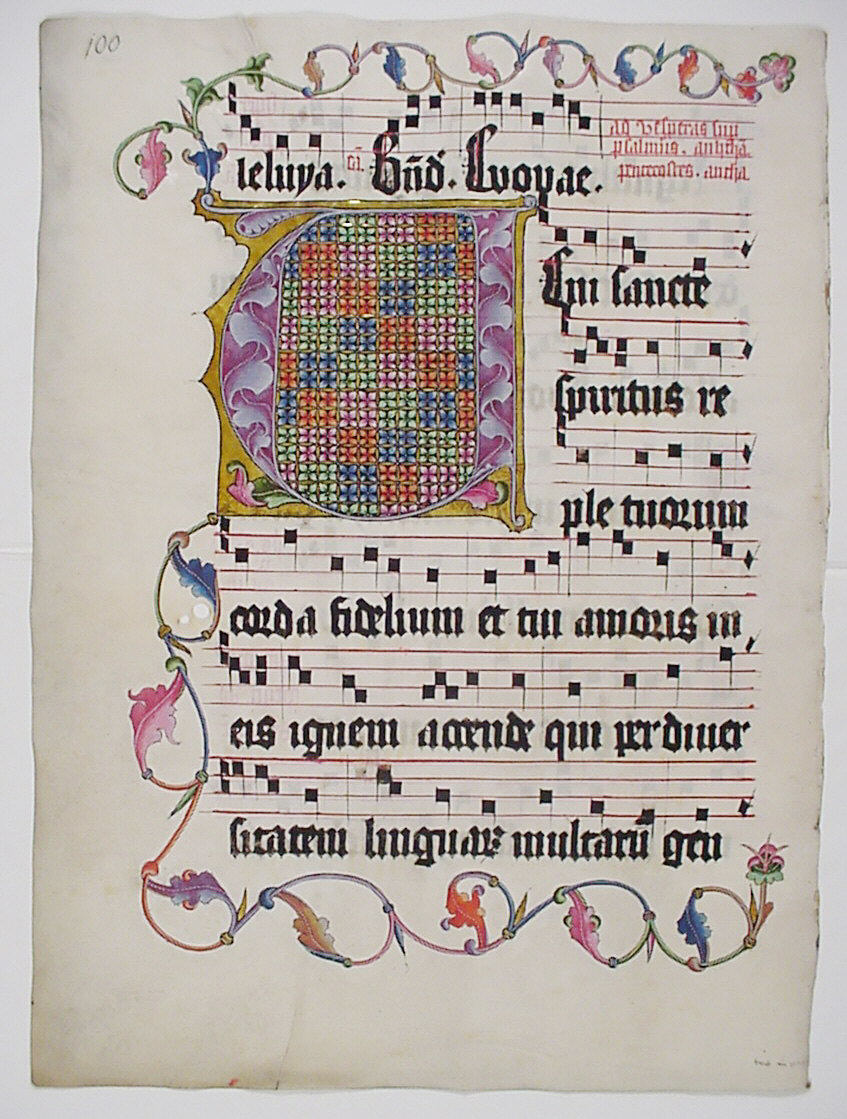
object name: antiphonary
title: Manuscript Leaf with Initial V, from an Antiphonary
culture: german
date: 1426-1450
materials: ink, metal leaf, parchment, paint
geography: germany